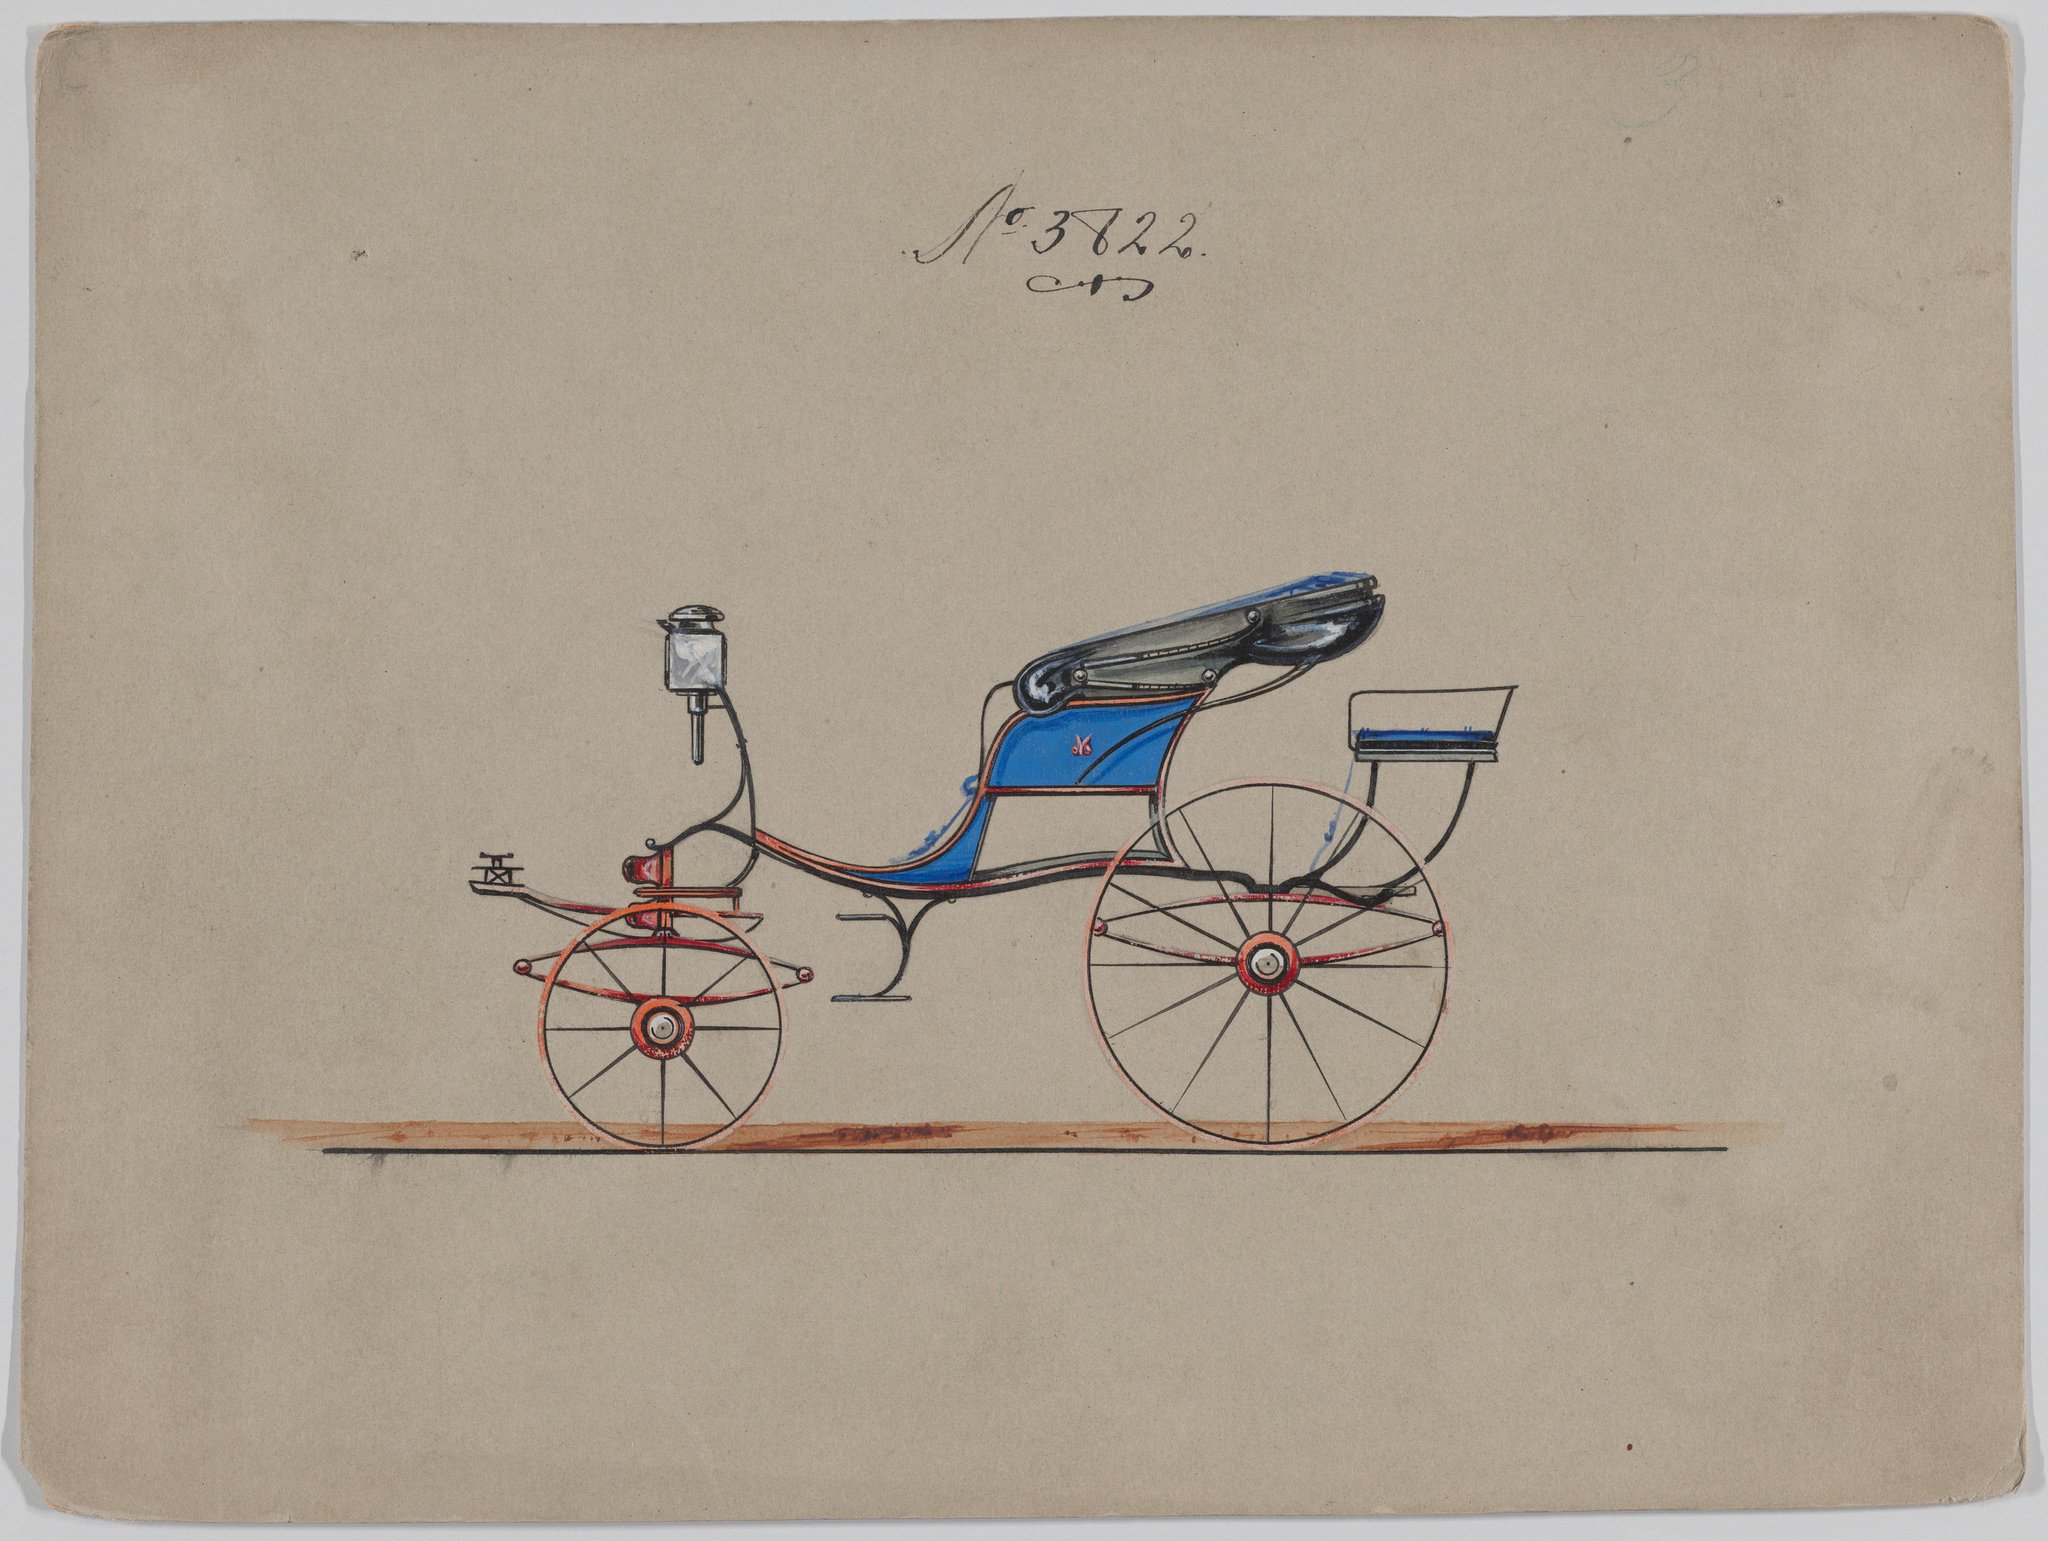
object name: drawing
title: Design for Pony Phaeton, no. 3822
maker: brewster & co.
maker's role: manufacturer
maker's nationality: american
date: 1883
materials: gouache, gum arabic, ink, watercolor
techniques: pen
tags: carriages